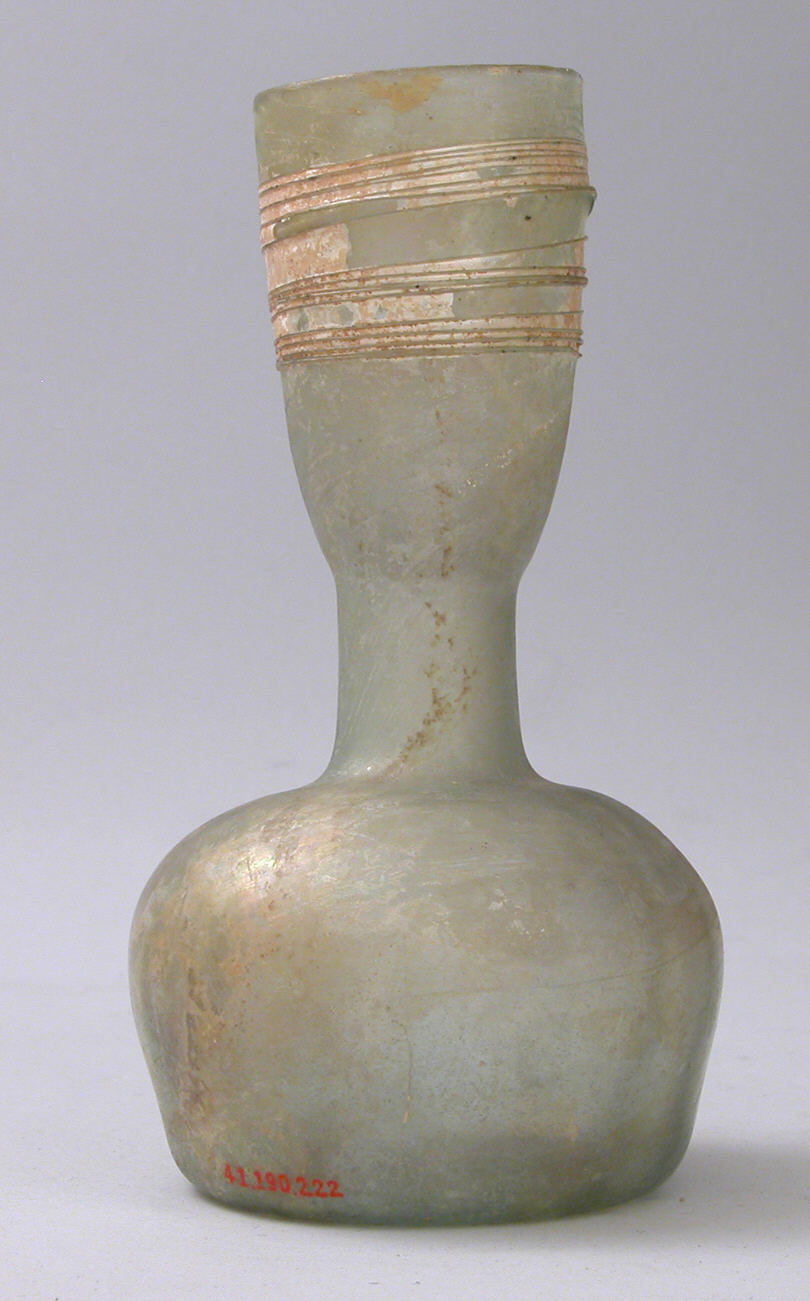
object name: bottle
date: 501-600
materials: glass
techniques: glassblowing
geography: egypt or syria